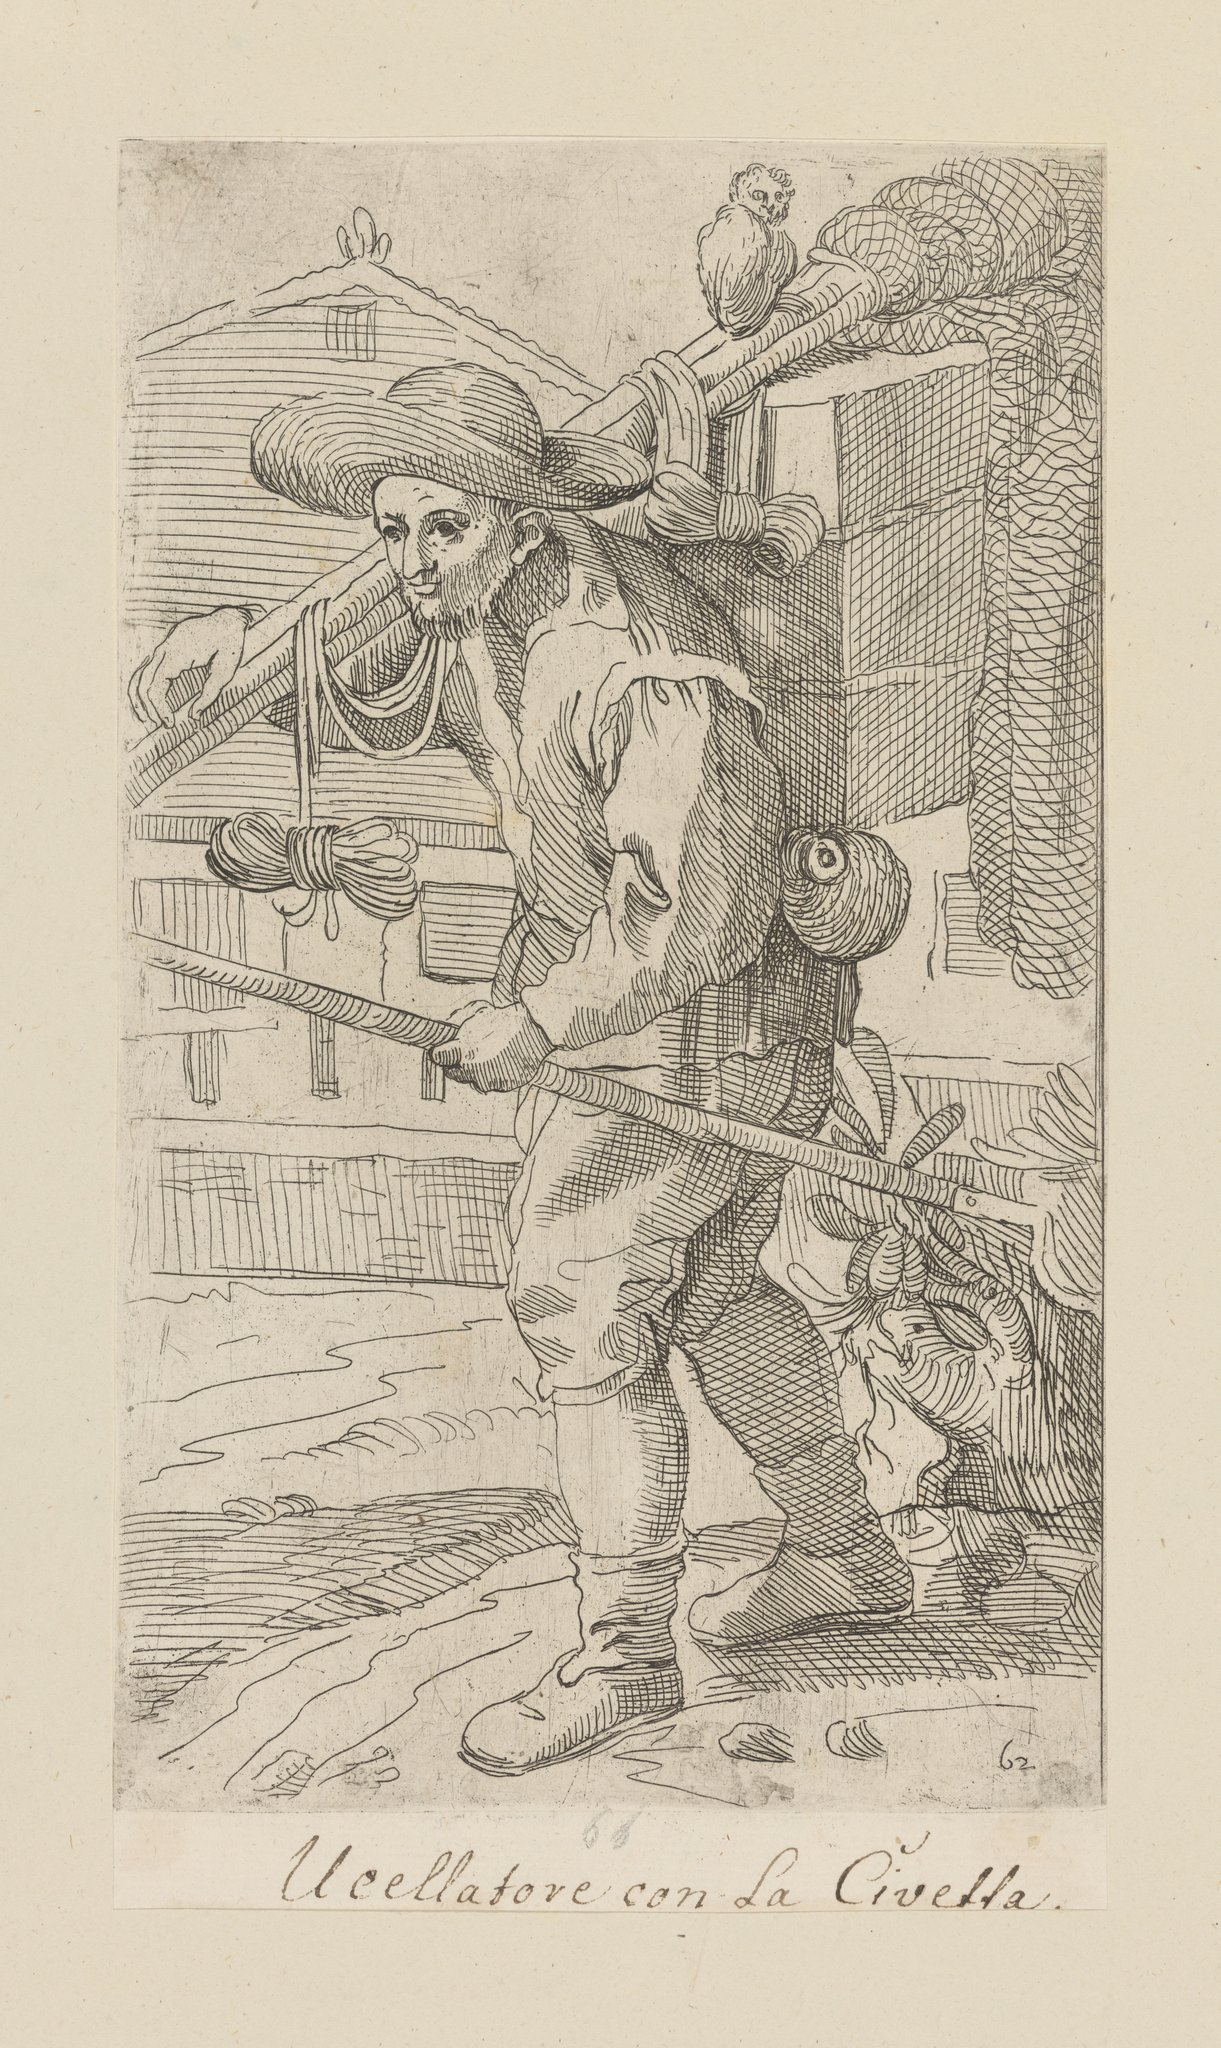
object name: print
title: Plate 62: Bird catcher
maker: simon guillain ii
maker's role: artist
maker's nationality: french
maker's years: 1618-1718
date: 1646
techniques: etching